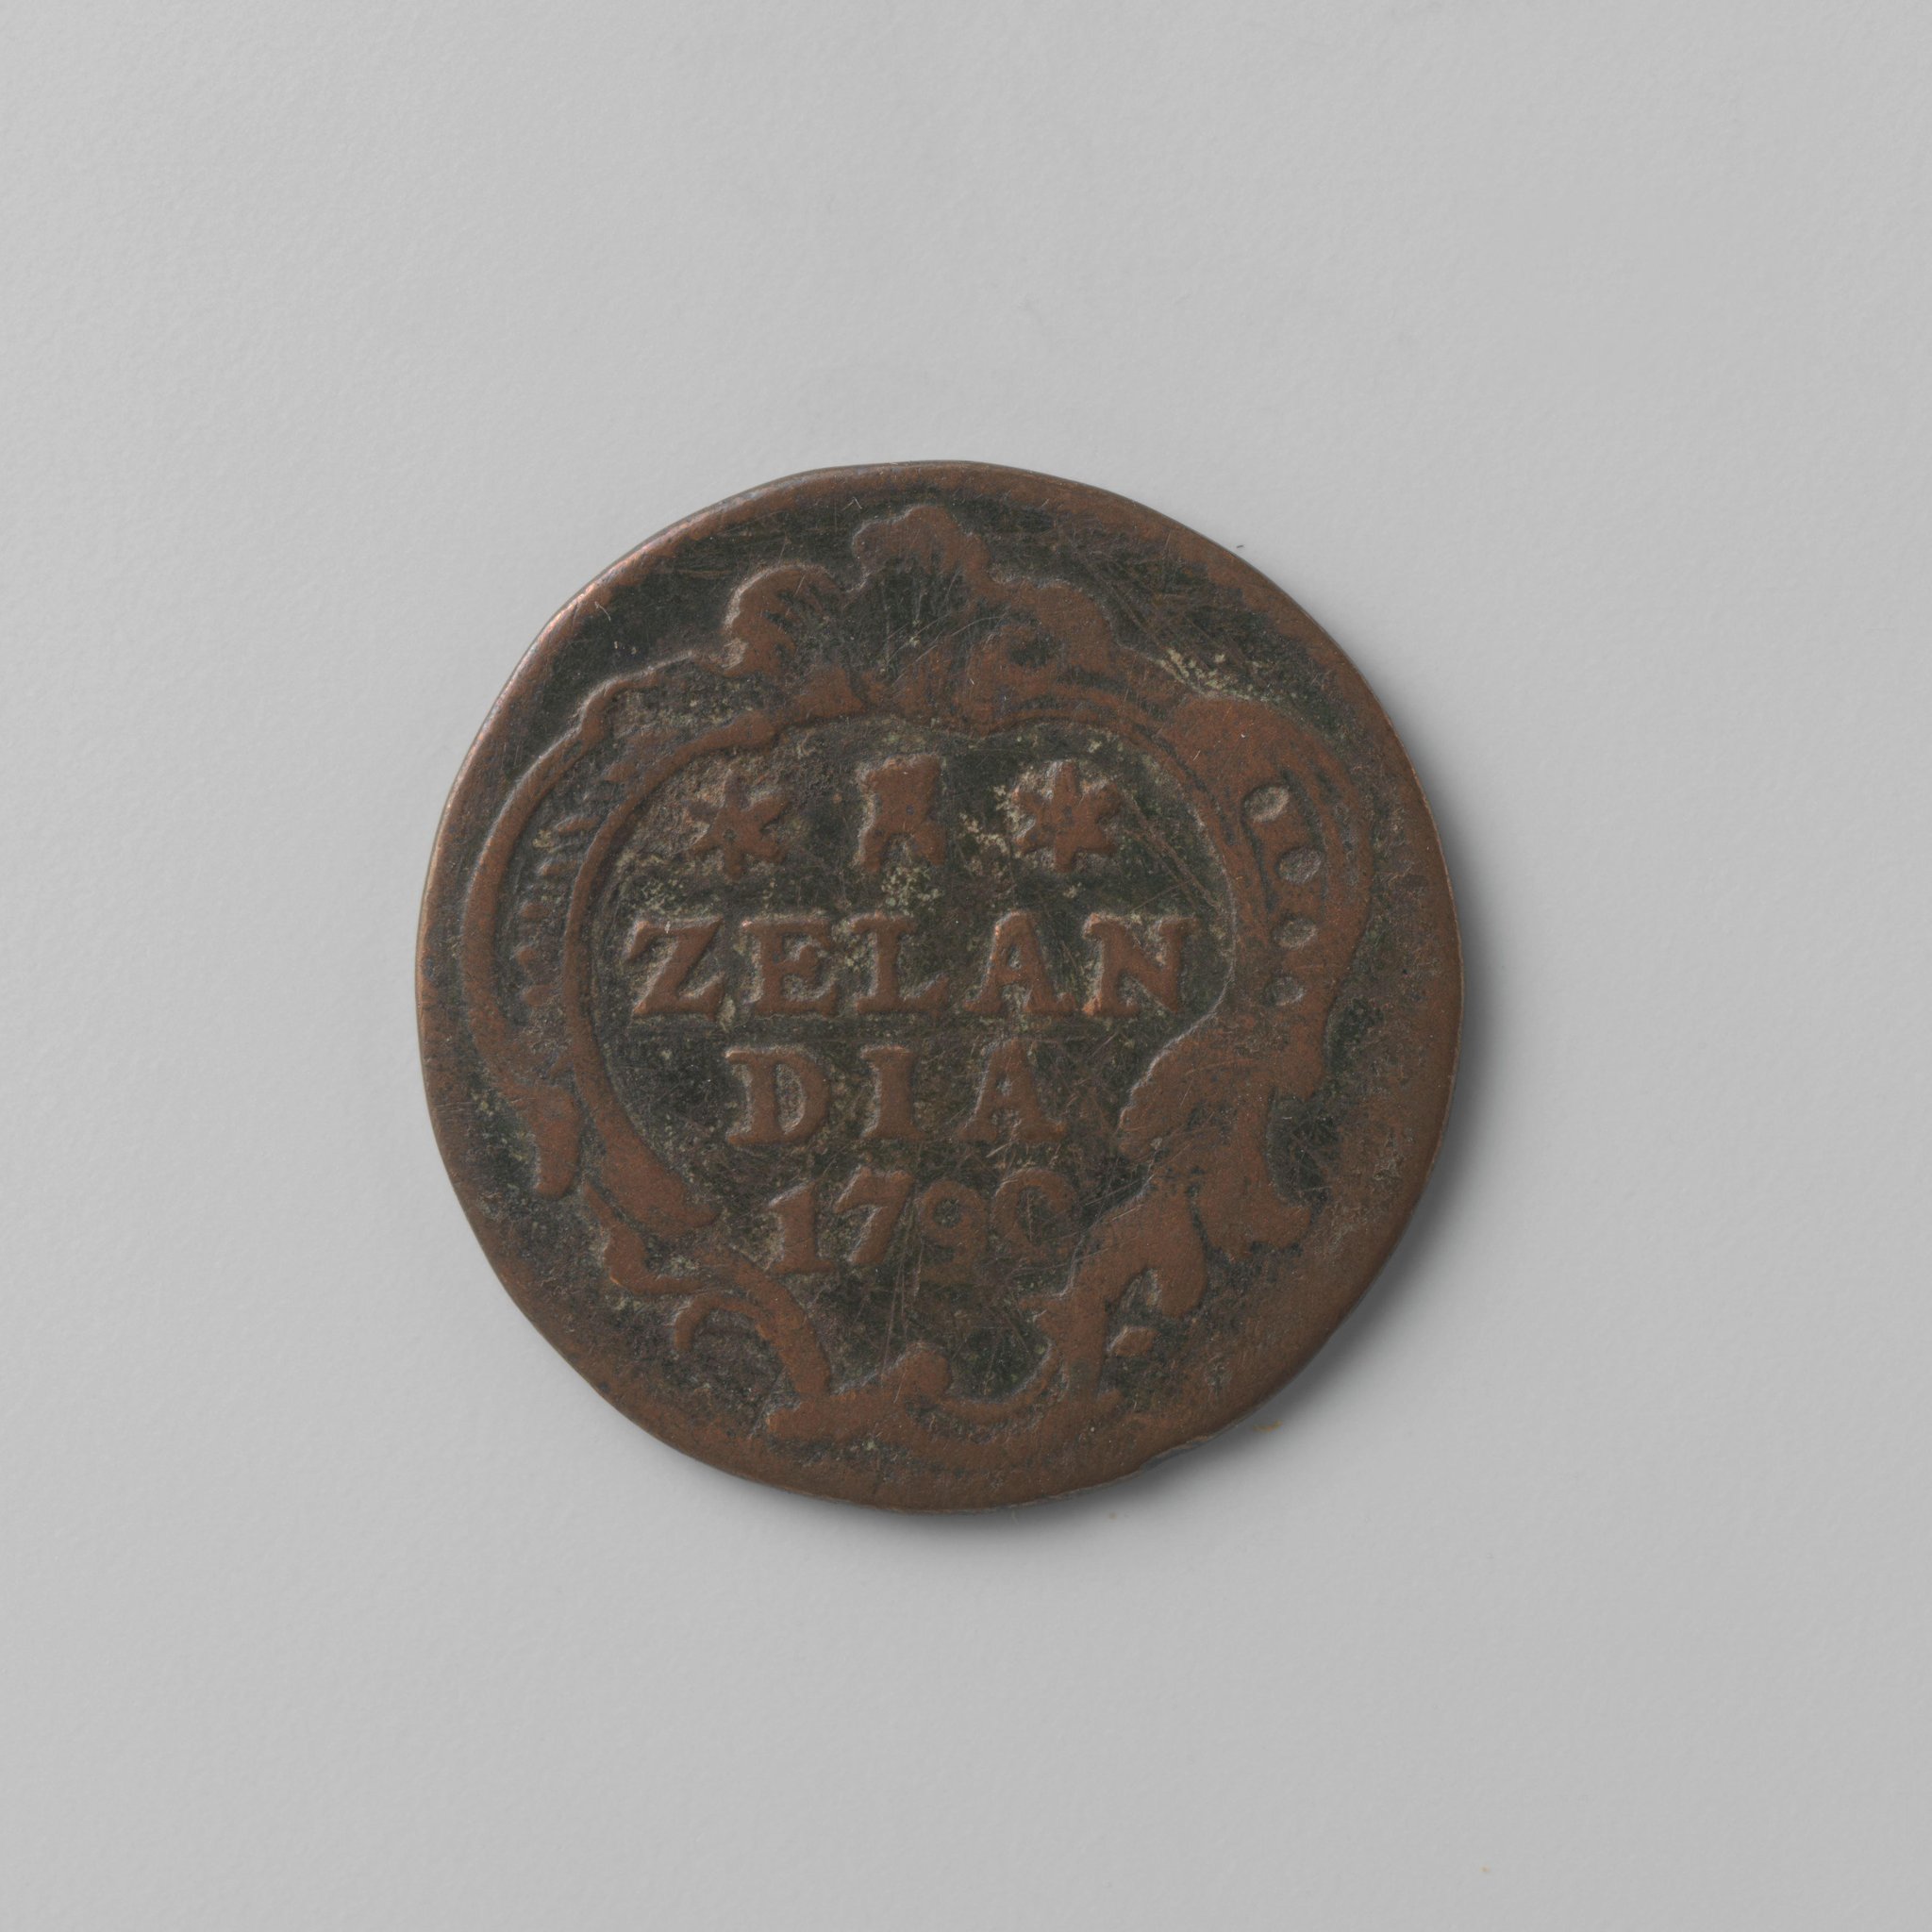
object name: coin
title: Zeeland, duit, 1790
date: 1790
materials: copper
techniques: striking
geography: middelburg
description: Koperen munt. Voorzijde: in rococo-lijst gekroond ovaal wapenschild van Zeeland. Keerzijde: in een rococo-versiering opschrift in drie regels, waarboven muntteken burcht tussen twee sterren en waaronder jaartal.